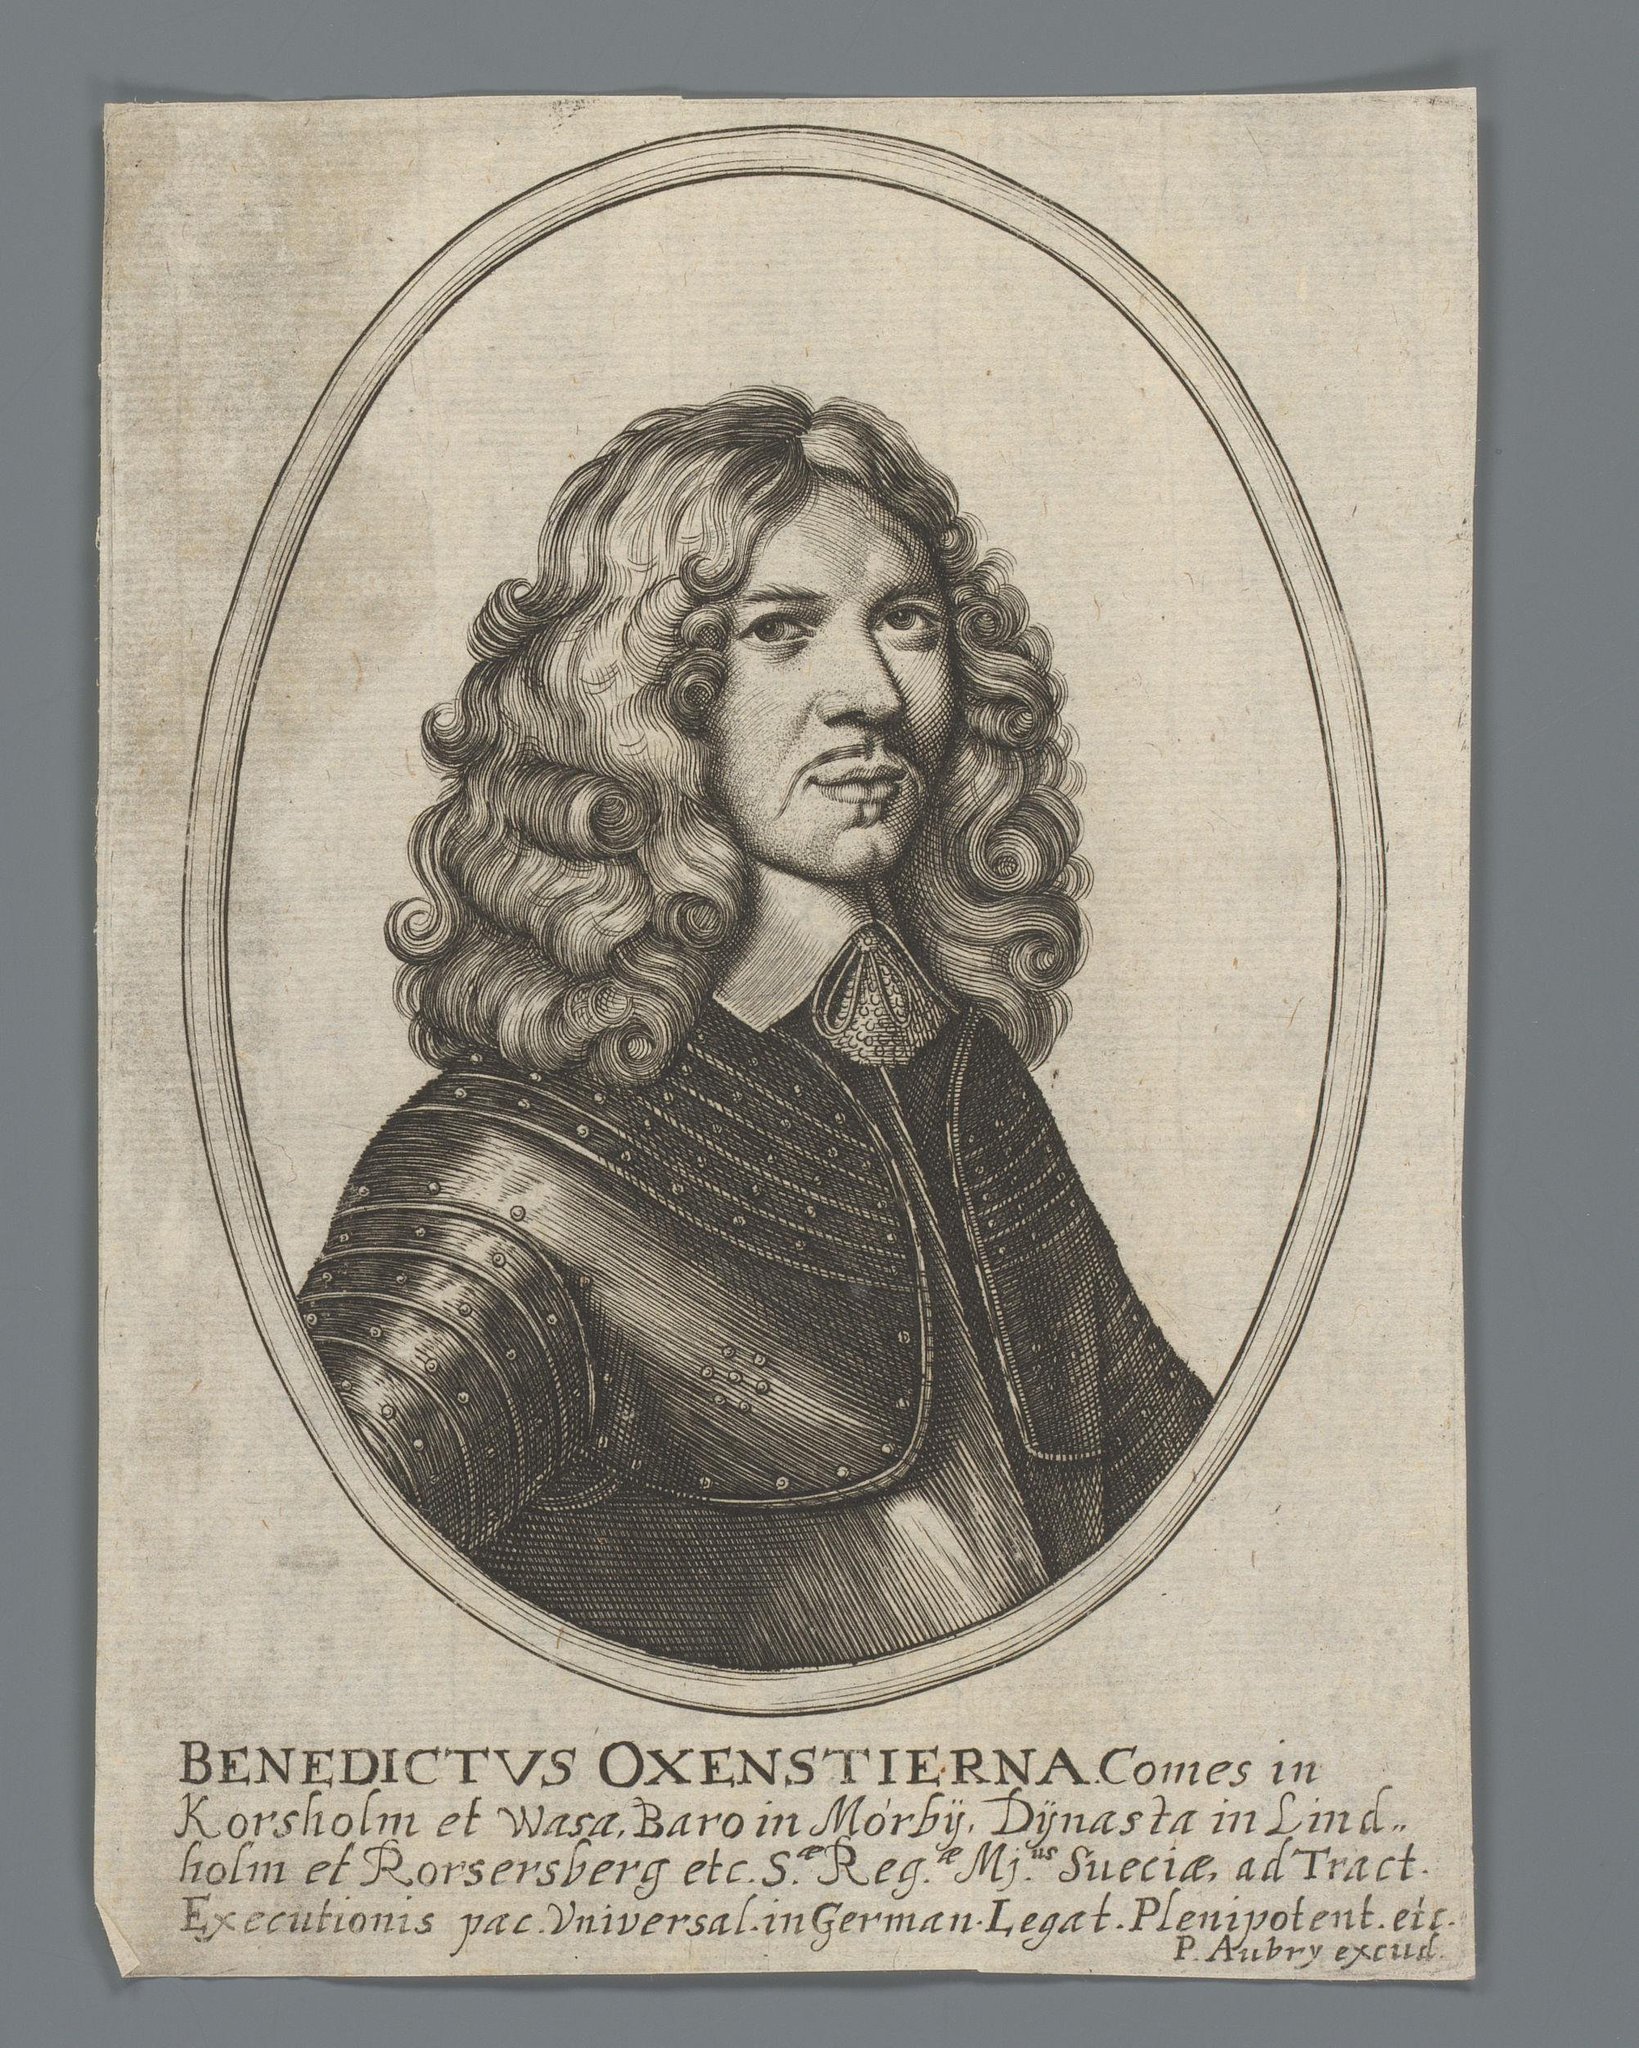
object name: print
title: Portret van Benedictus Oxenstierna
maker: Anonymous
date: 1648-1650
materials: paper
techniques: engraving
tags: historical persons, diplomacy, diplomat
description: Met vierregelig onderschrift in het Latijn.